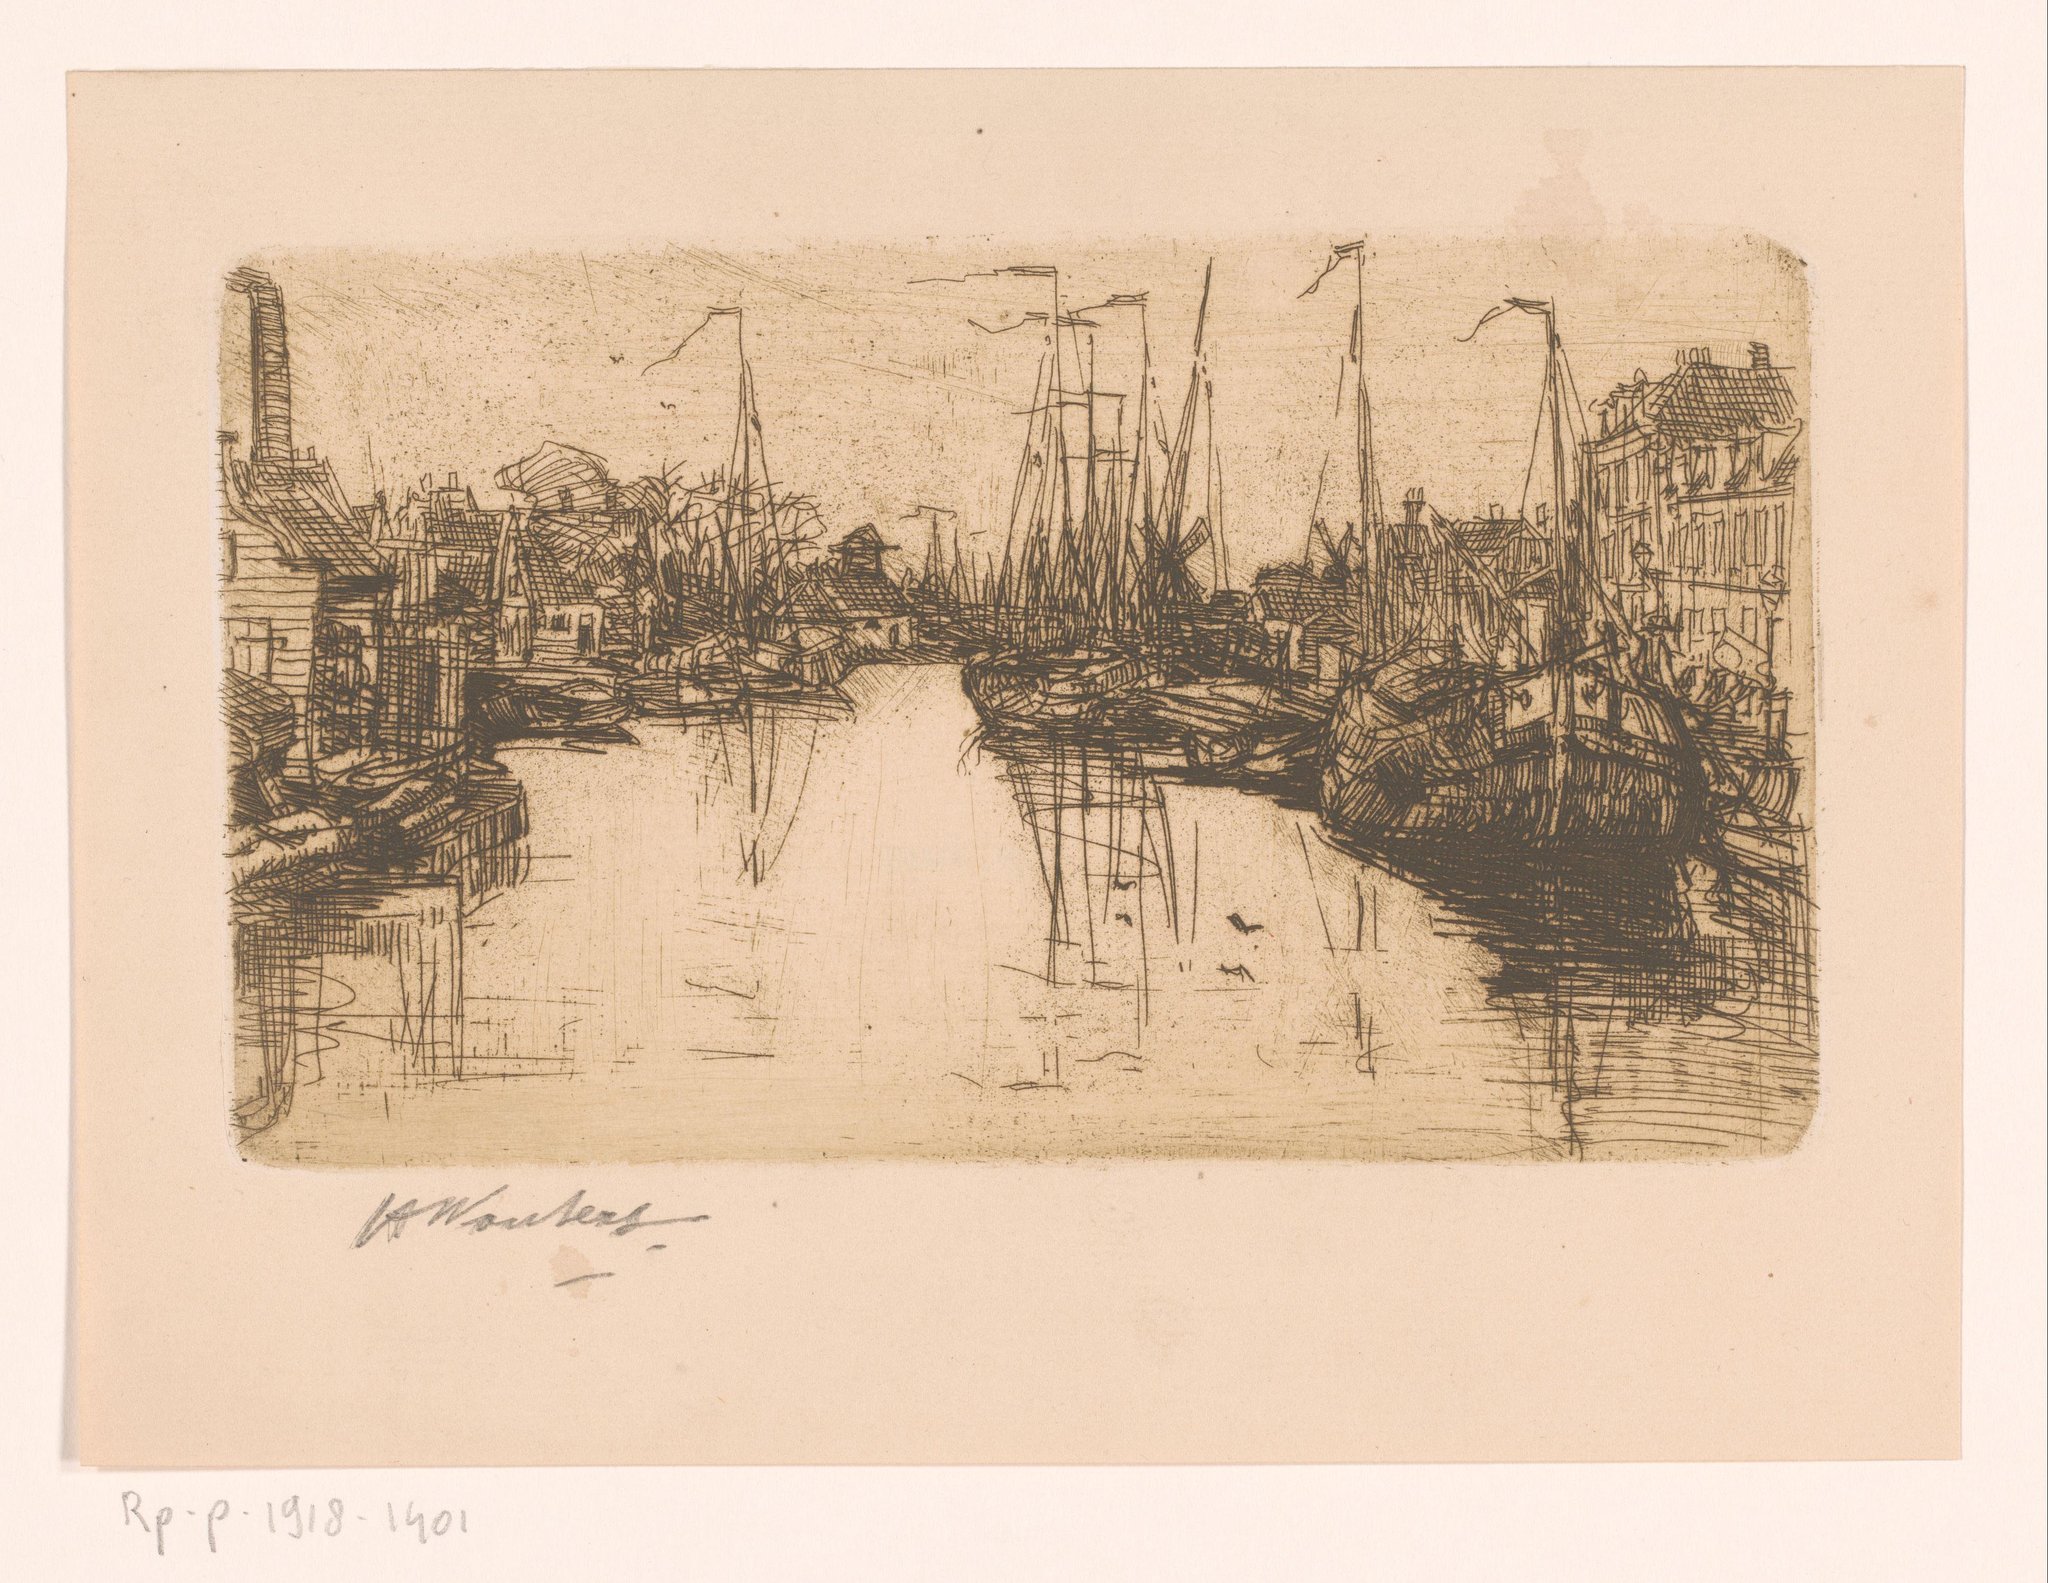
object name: print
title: Stadsgracht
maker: henri wouters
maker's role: draughtsman, print maker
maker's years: 1866-1935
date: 1876-1918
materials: paper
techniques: drypoint, etching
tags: canal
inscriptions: collector's mark: Lugt 2228